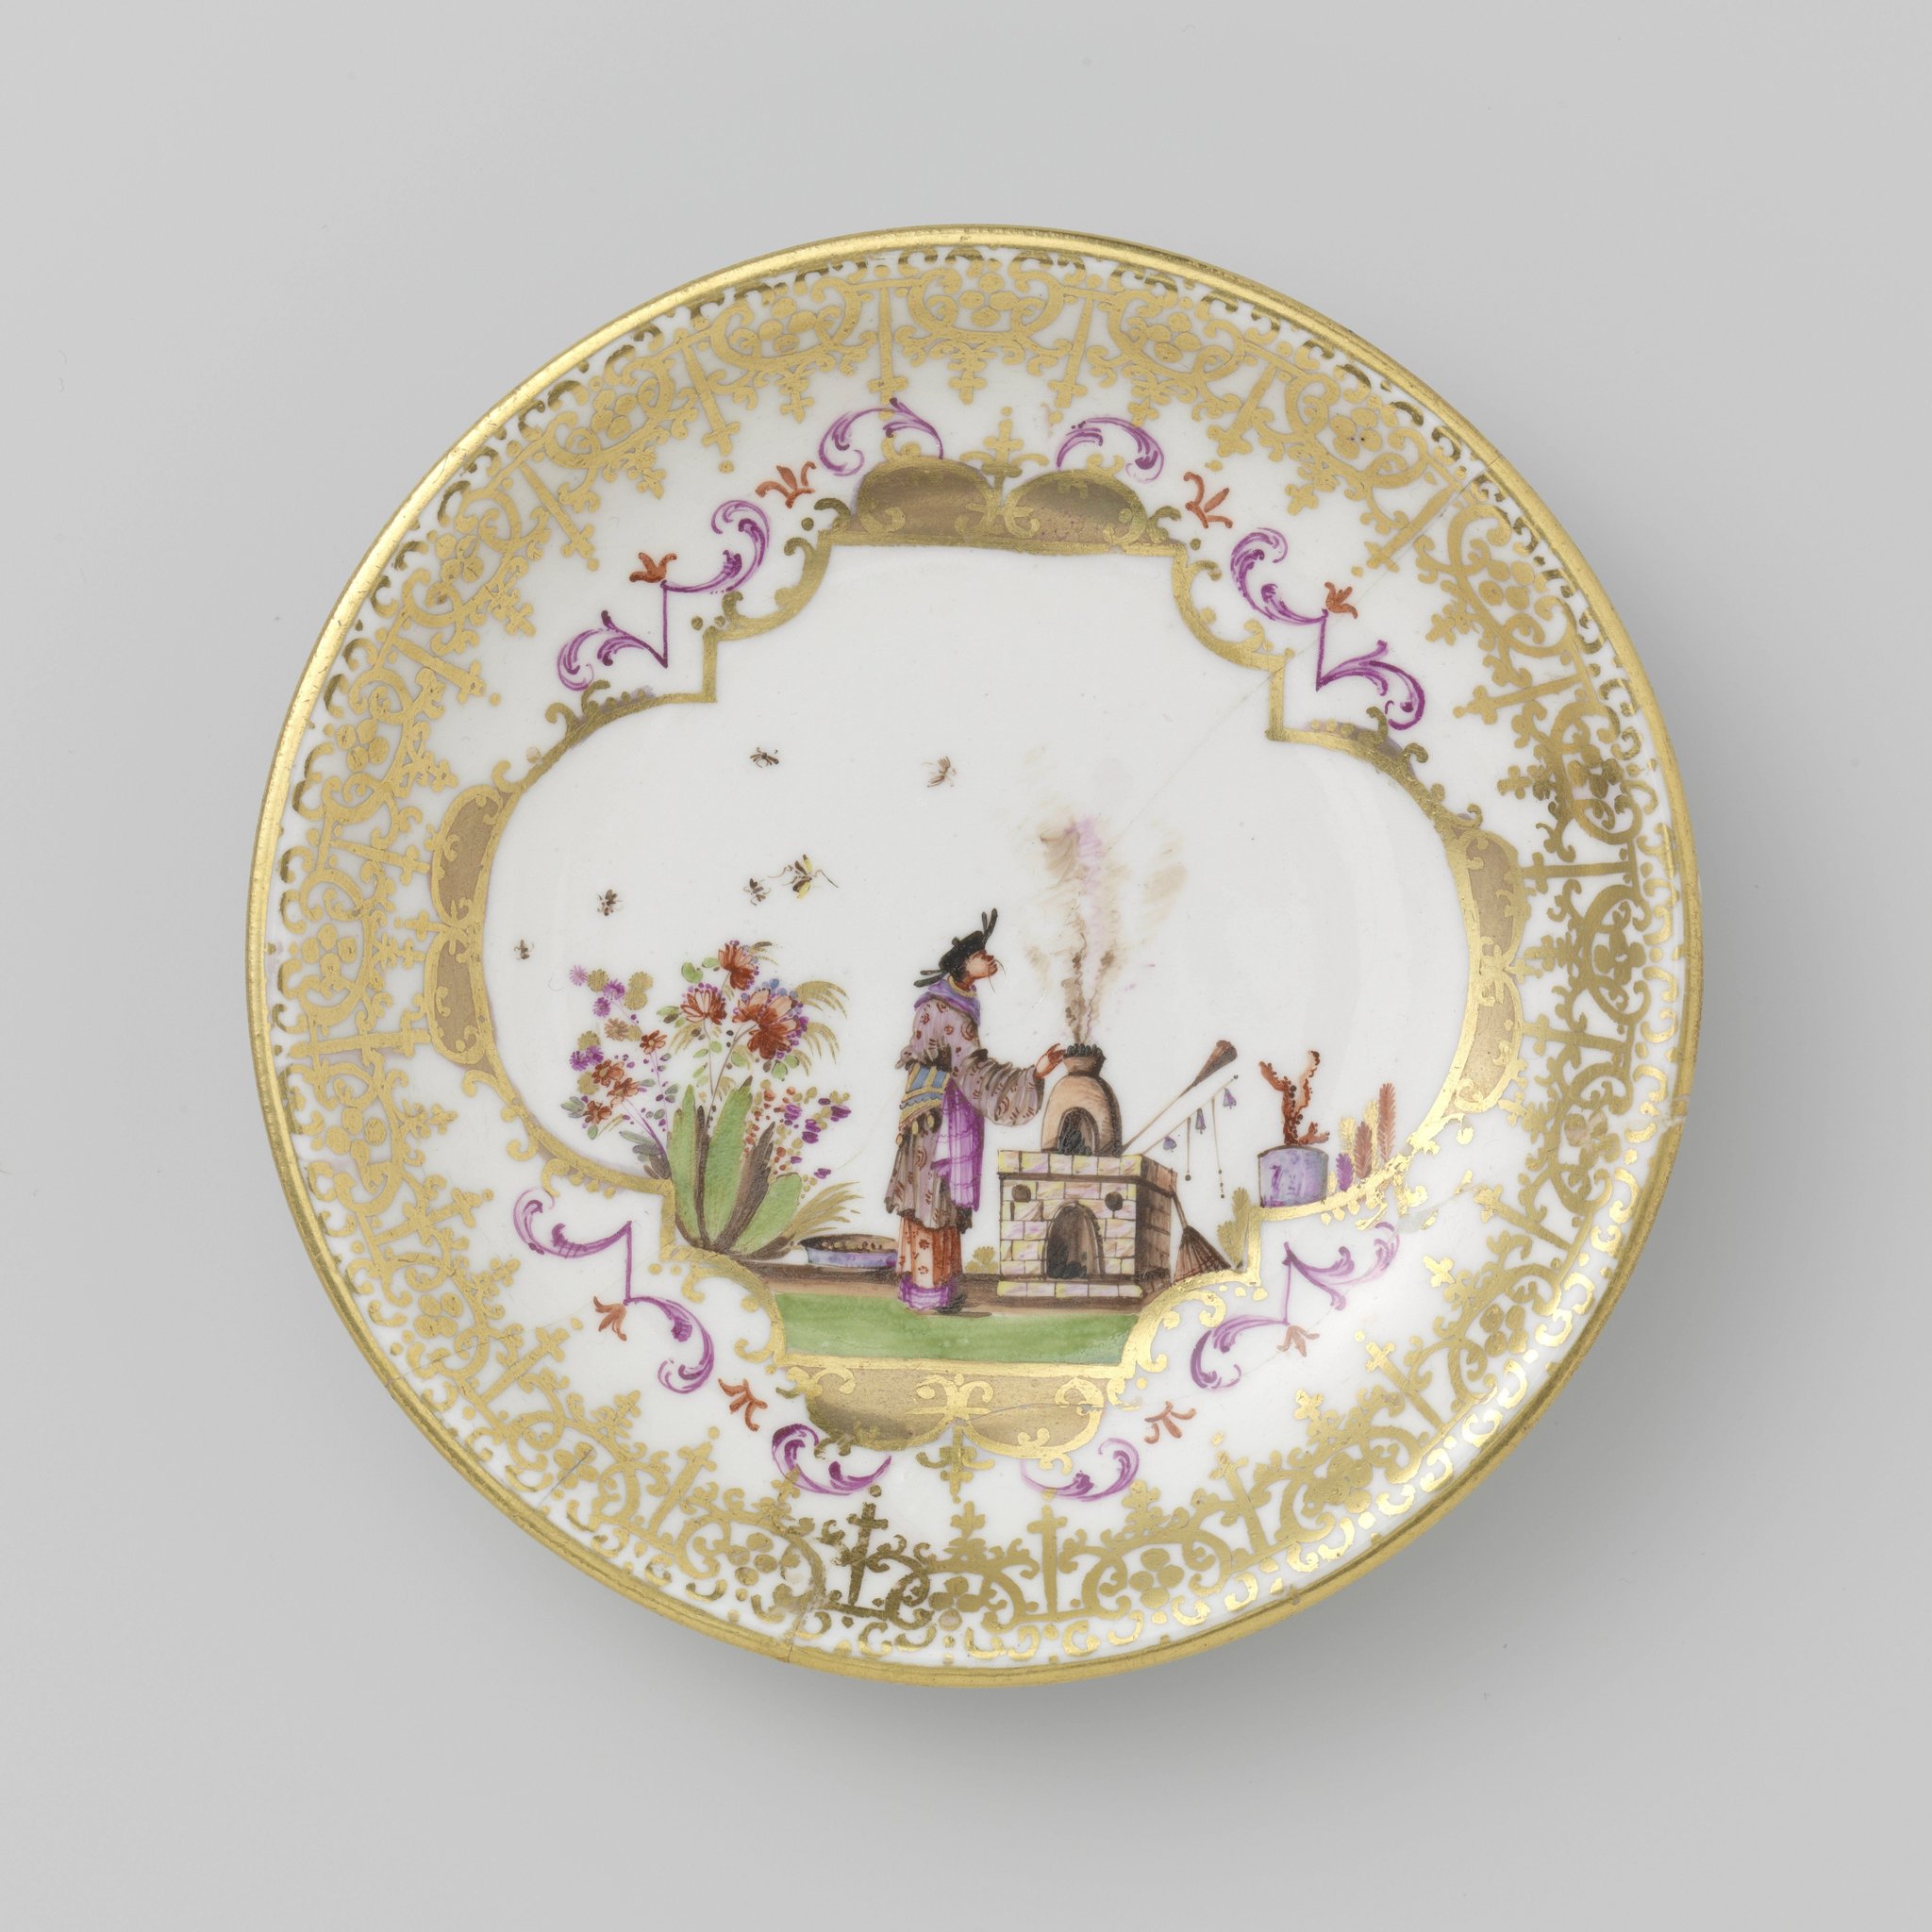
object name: eating drinking utensil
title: Schotel, veelkleurig beschilderd met chinoiserieën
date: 1725-1730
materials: porcelain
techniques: painted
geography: meissen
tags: catharina de grote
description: Tea service on silver-gilt stand. Porcelain and silver gilt. Meissen, c. 1725 - 1730, the stand Augsburg, c. 1730, by Johannes Engelbrecht. From the possessions of Catharine the Great of Russia